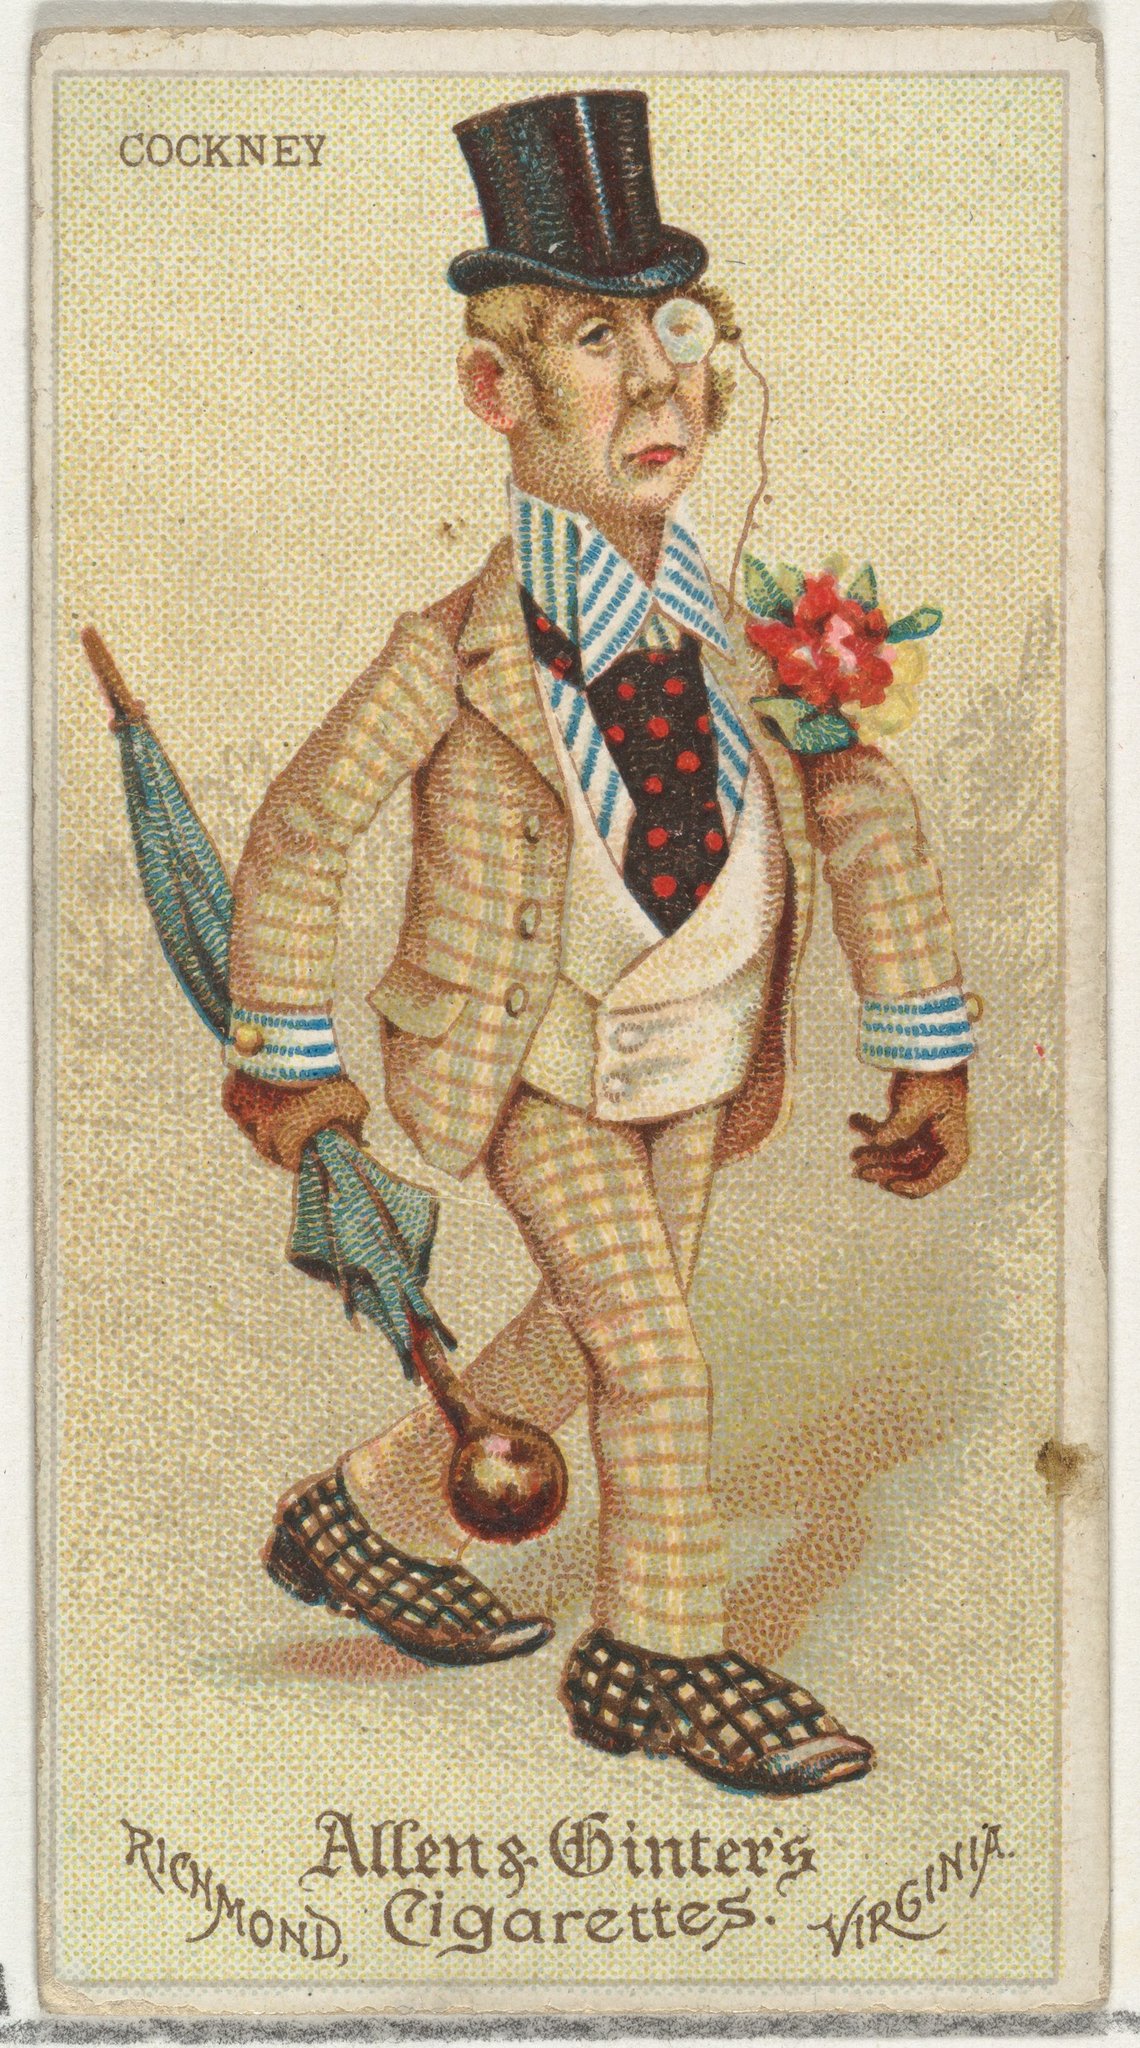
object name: print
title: Cockney, from World's Dudes series (N31) for Allen & Ginter Cigarettes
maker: allen & ginter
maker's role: publisher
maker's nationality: american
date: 1888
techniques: color lithograph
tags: men,umbrellas